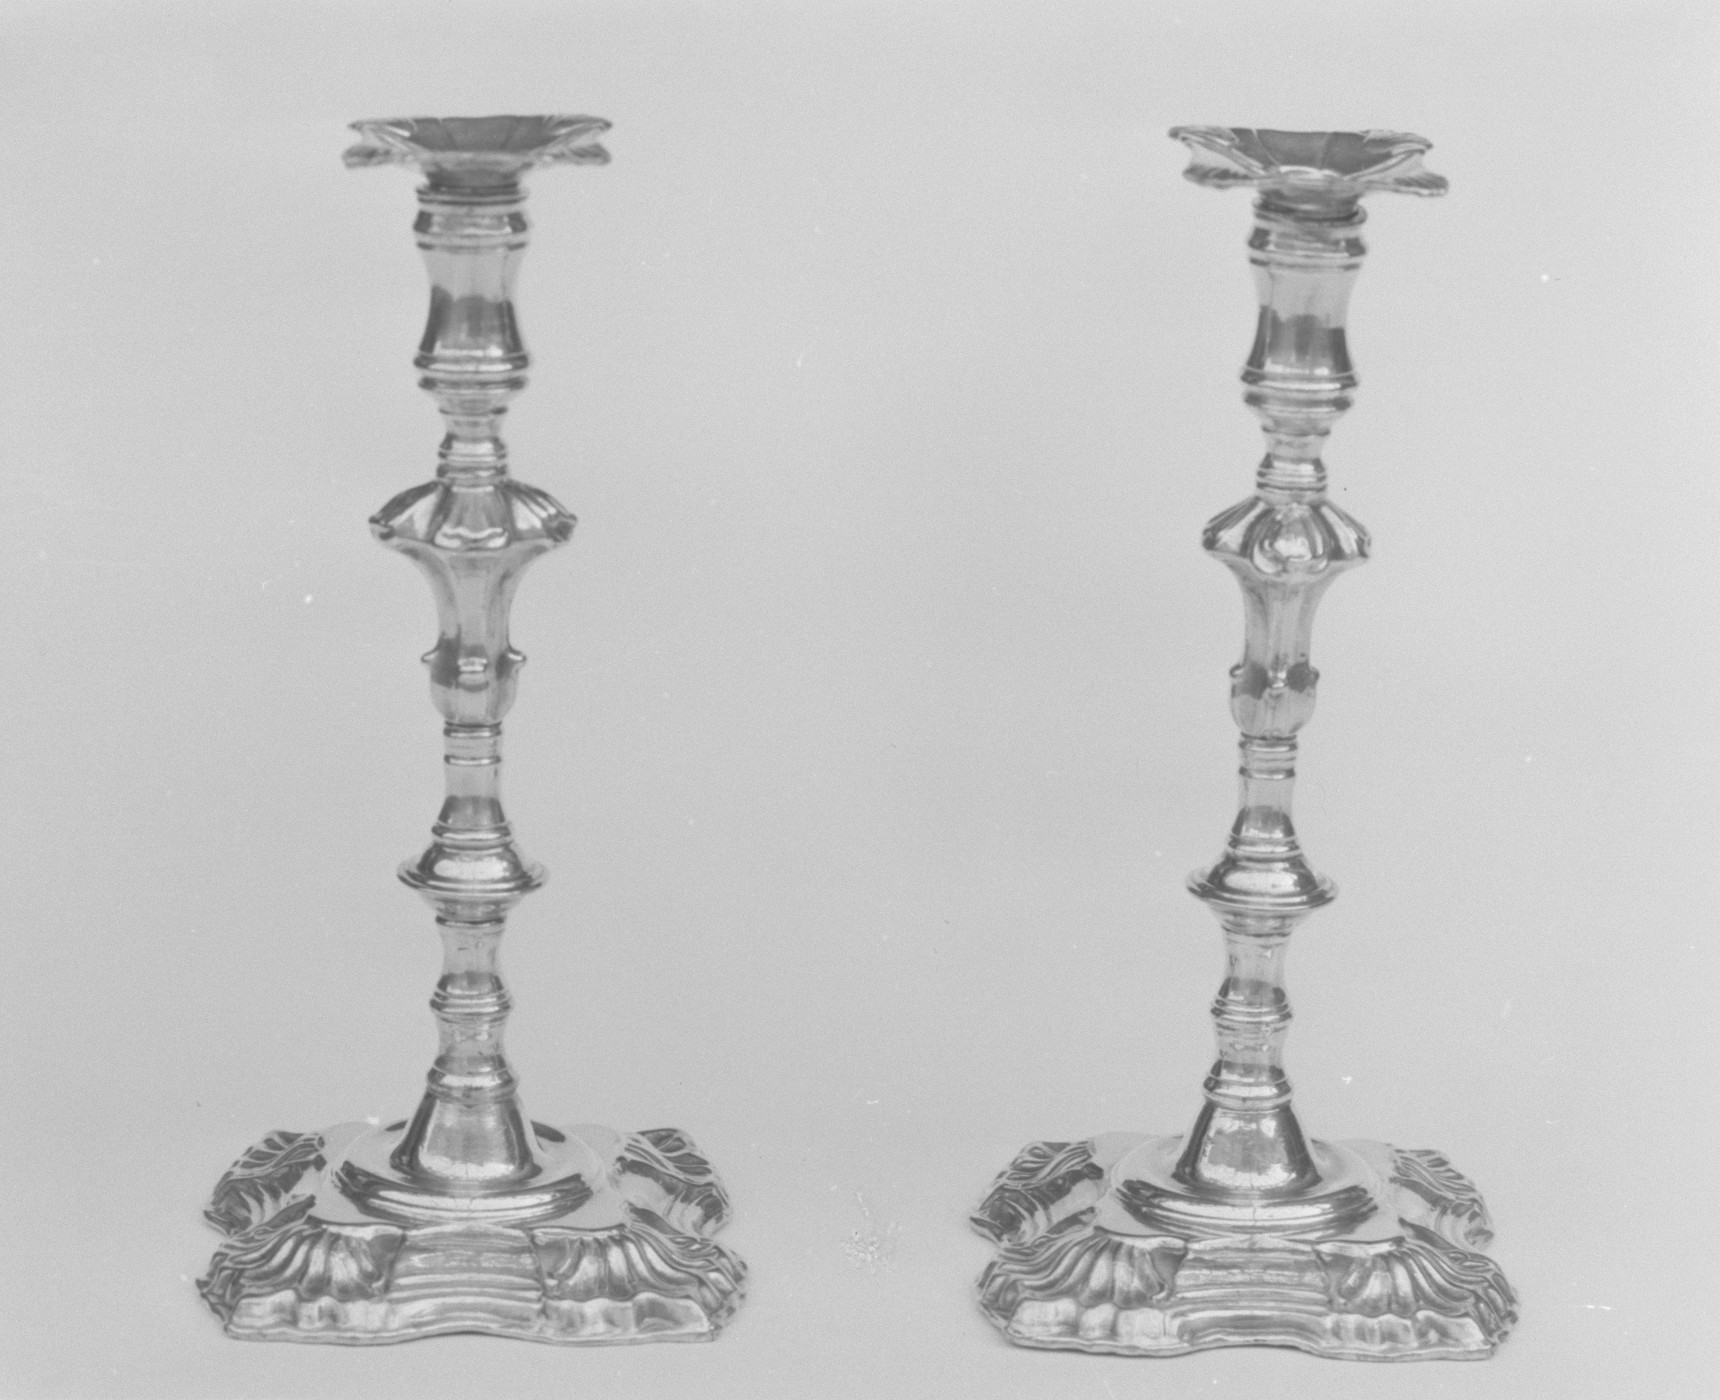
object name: taperstick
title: Pair of tapersticks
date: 1835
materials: metal